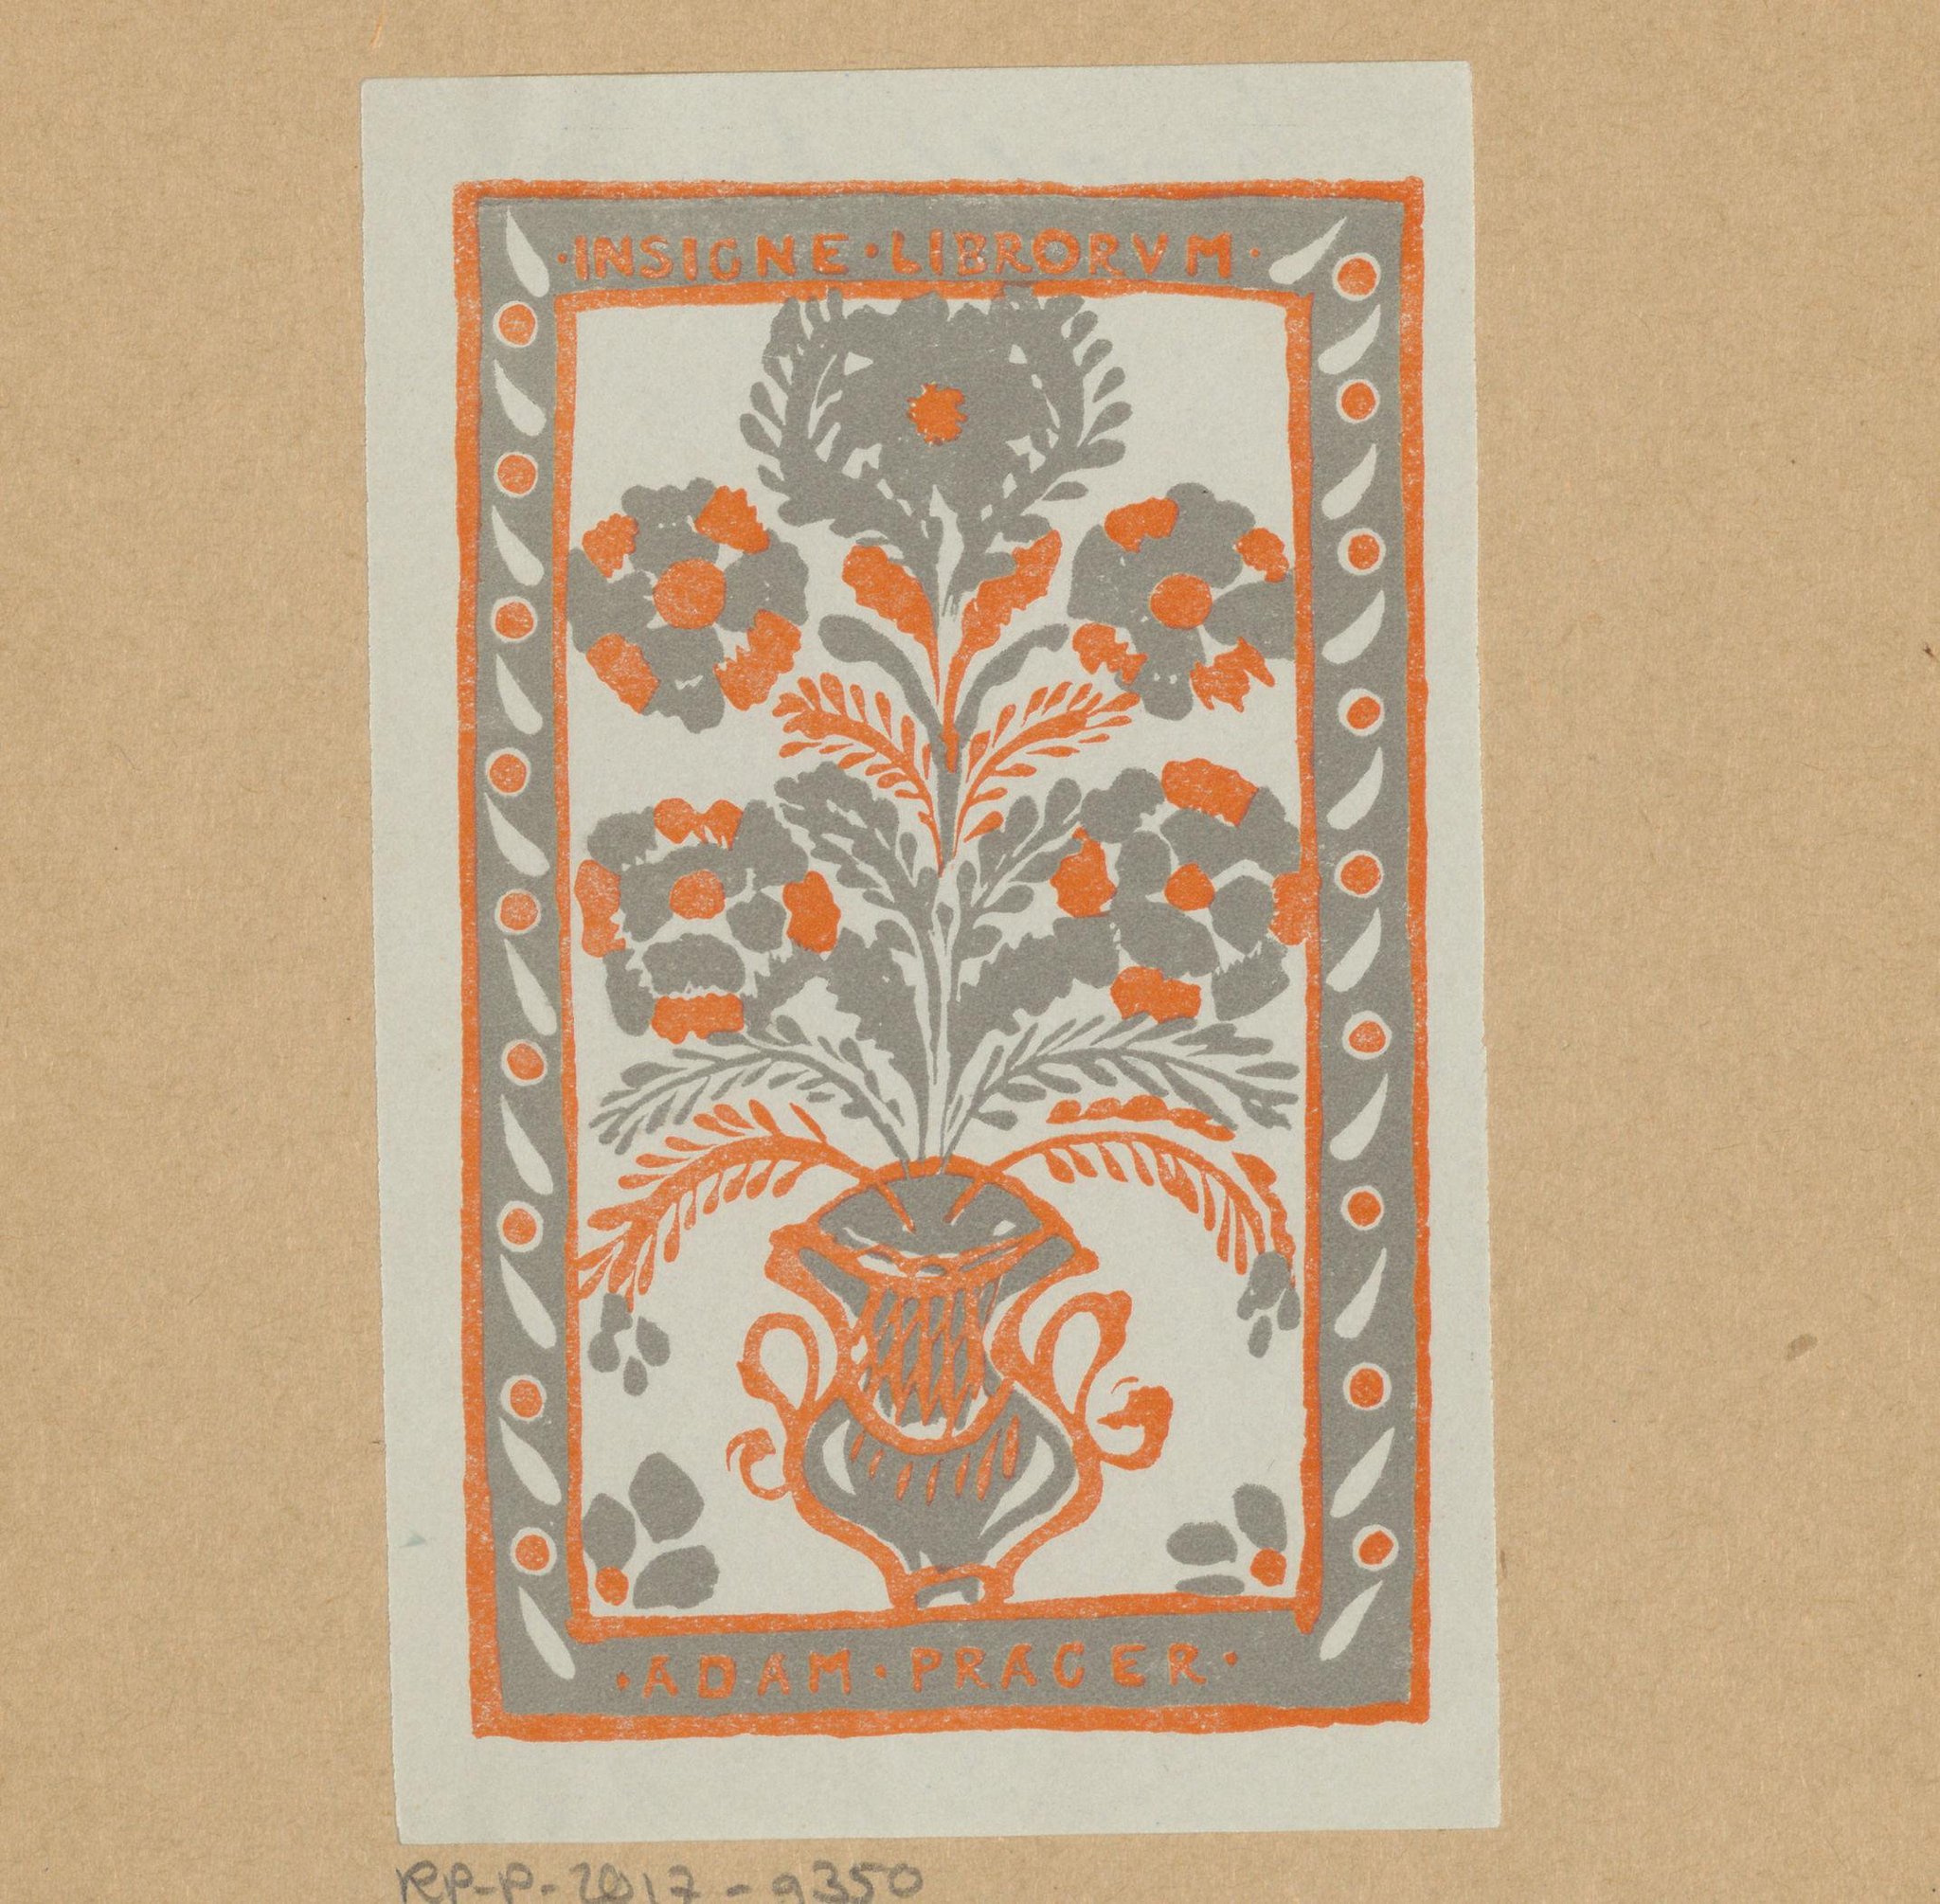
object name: bookplate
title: Ex libris van Adam Prager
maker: Anonymous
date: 1900-1999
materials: paper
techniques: printing block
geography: poland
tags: cut flowers; nosegay, bunch of flowers